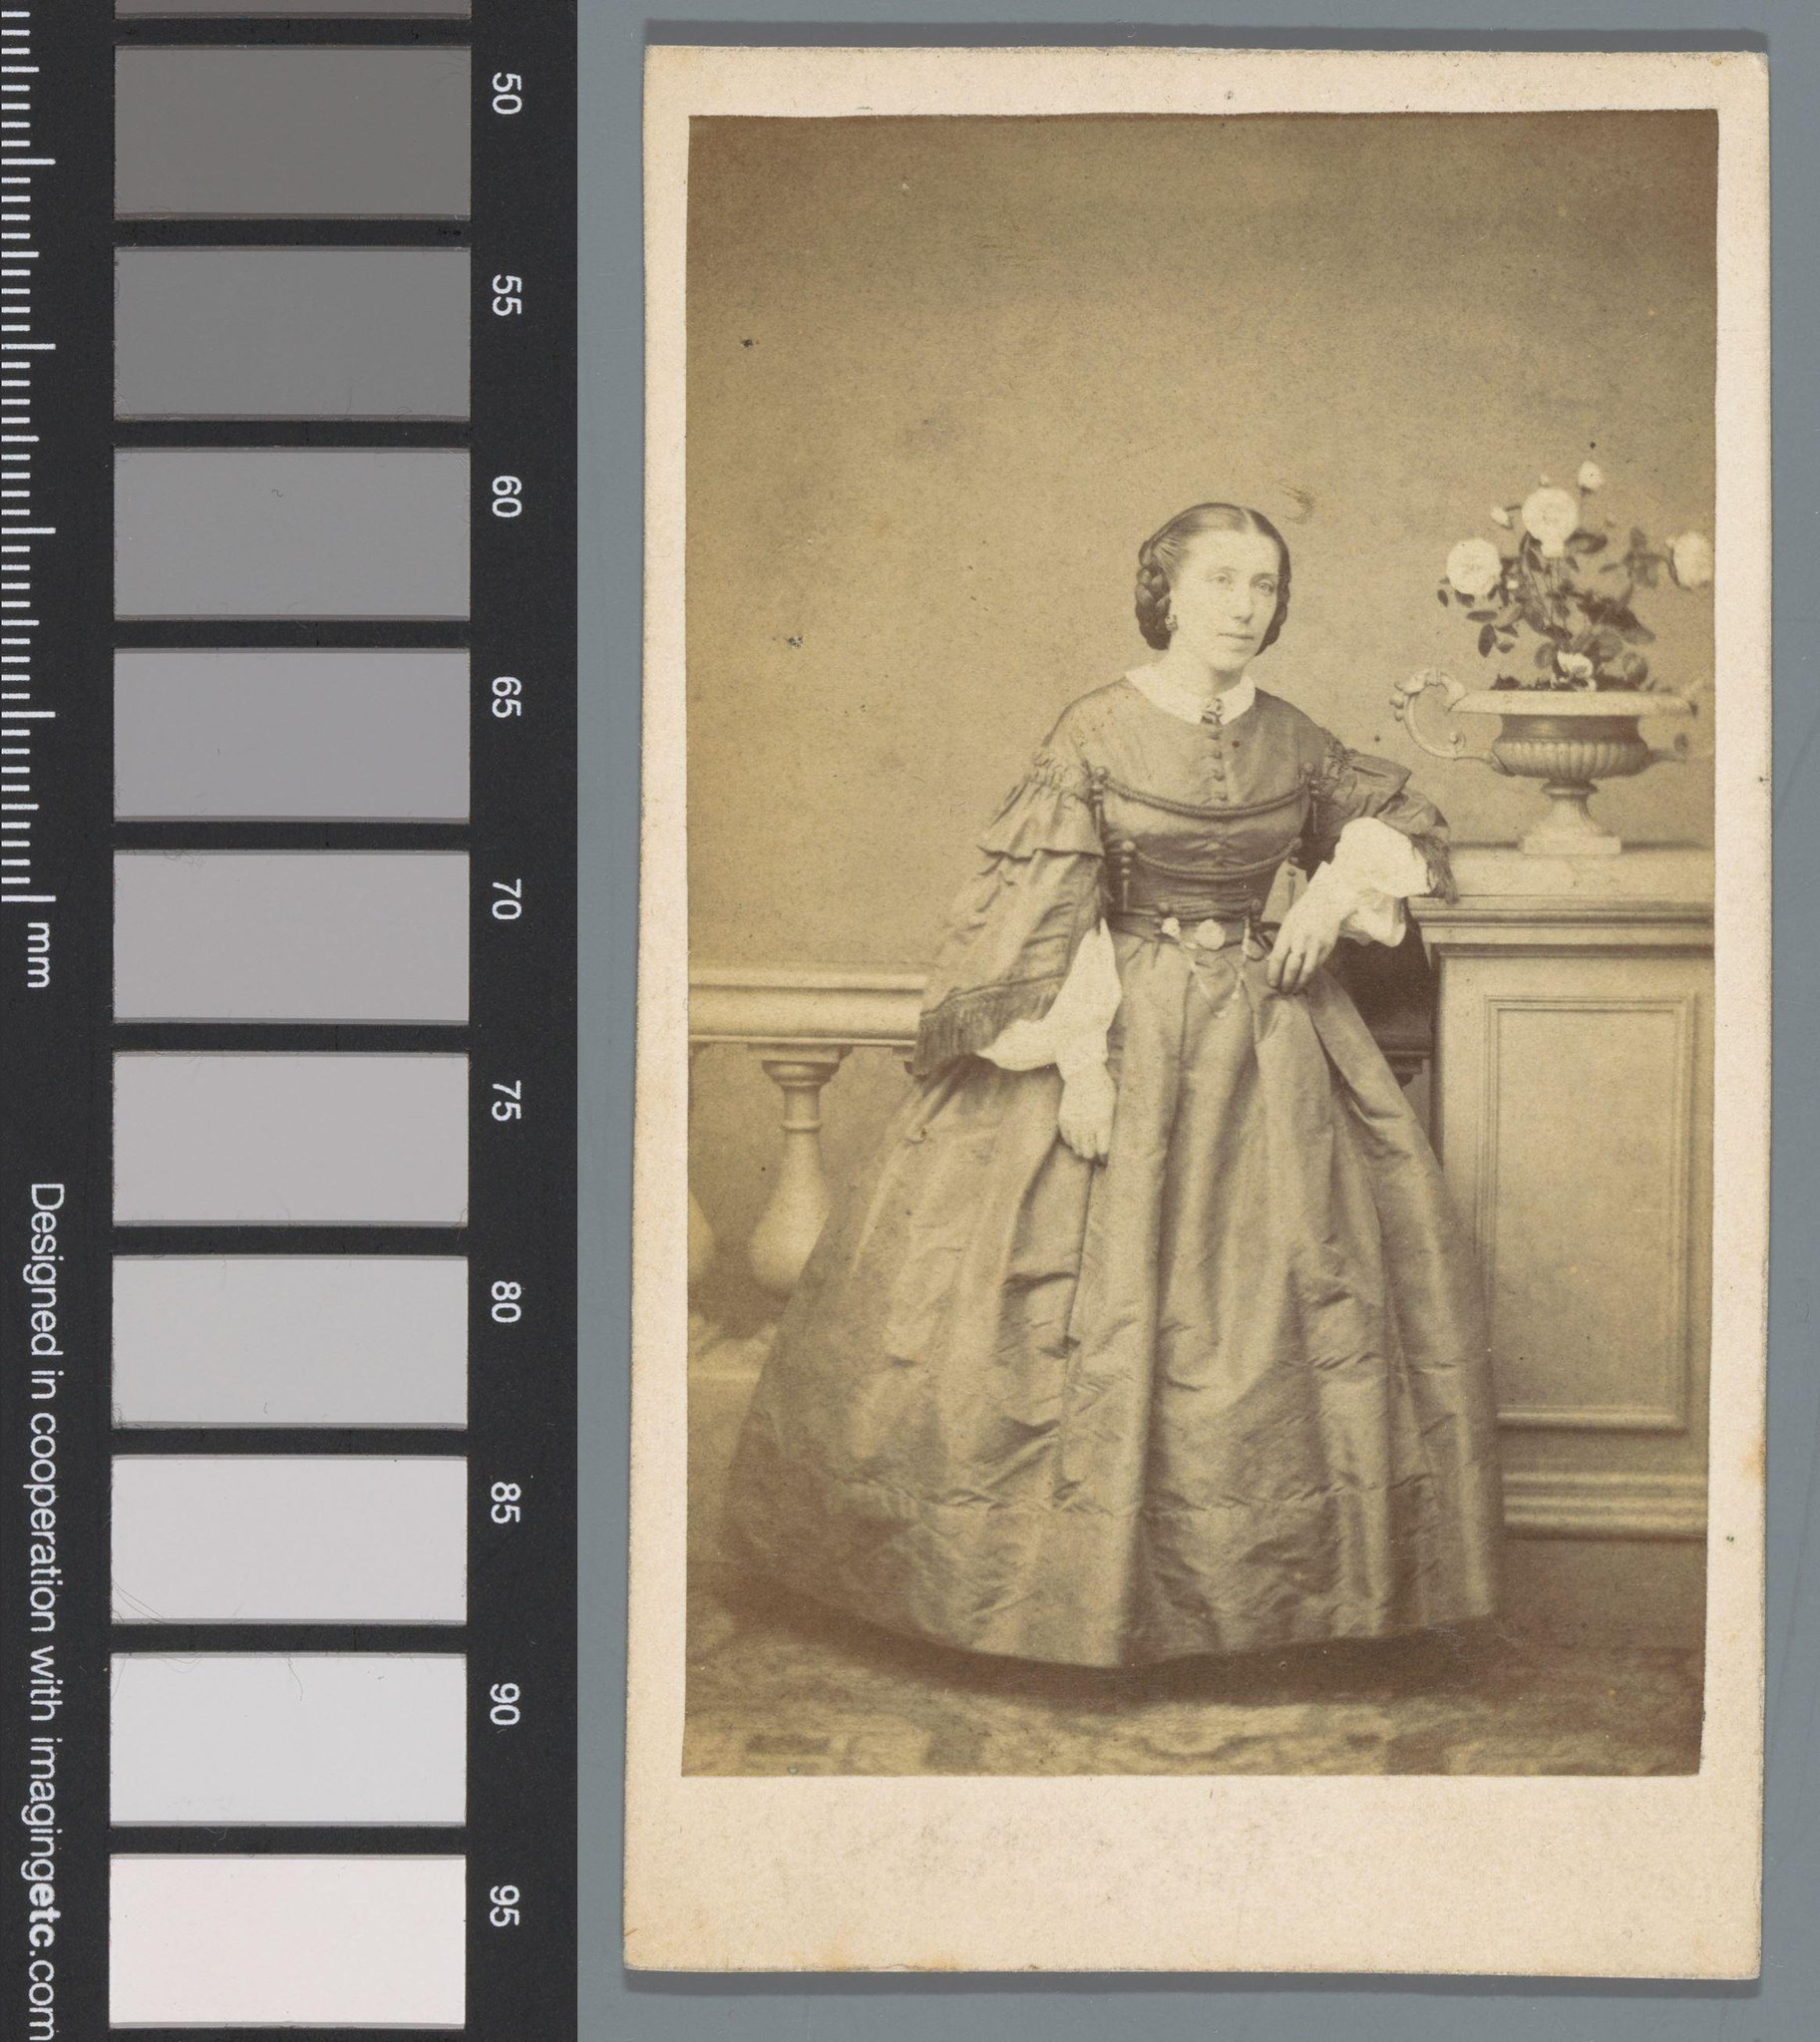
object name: carte de visite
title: Portret van een onbekende vrouw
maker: adolphe anjoux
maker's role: fotograaf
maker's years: 1817-1889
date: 1855-1885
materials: cardboard, paper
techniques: albumen print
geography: paris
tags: adult woman, anonymous historical person portrayed, paris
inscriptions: inscription: ‘Ad. Anjoux/ photographe/ Rue St. Honoré, 270./ Paris’